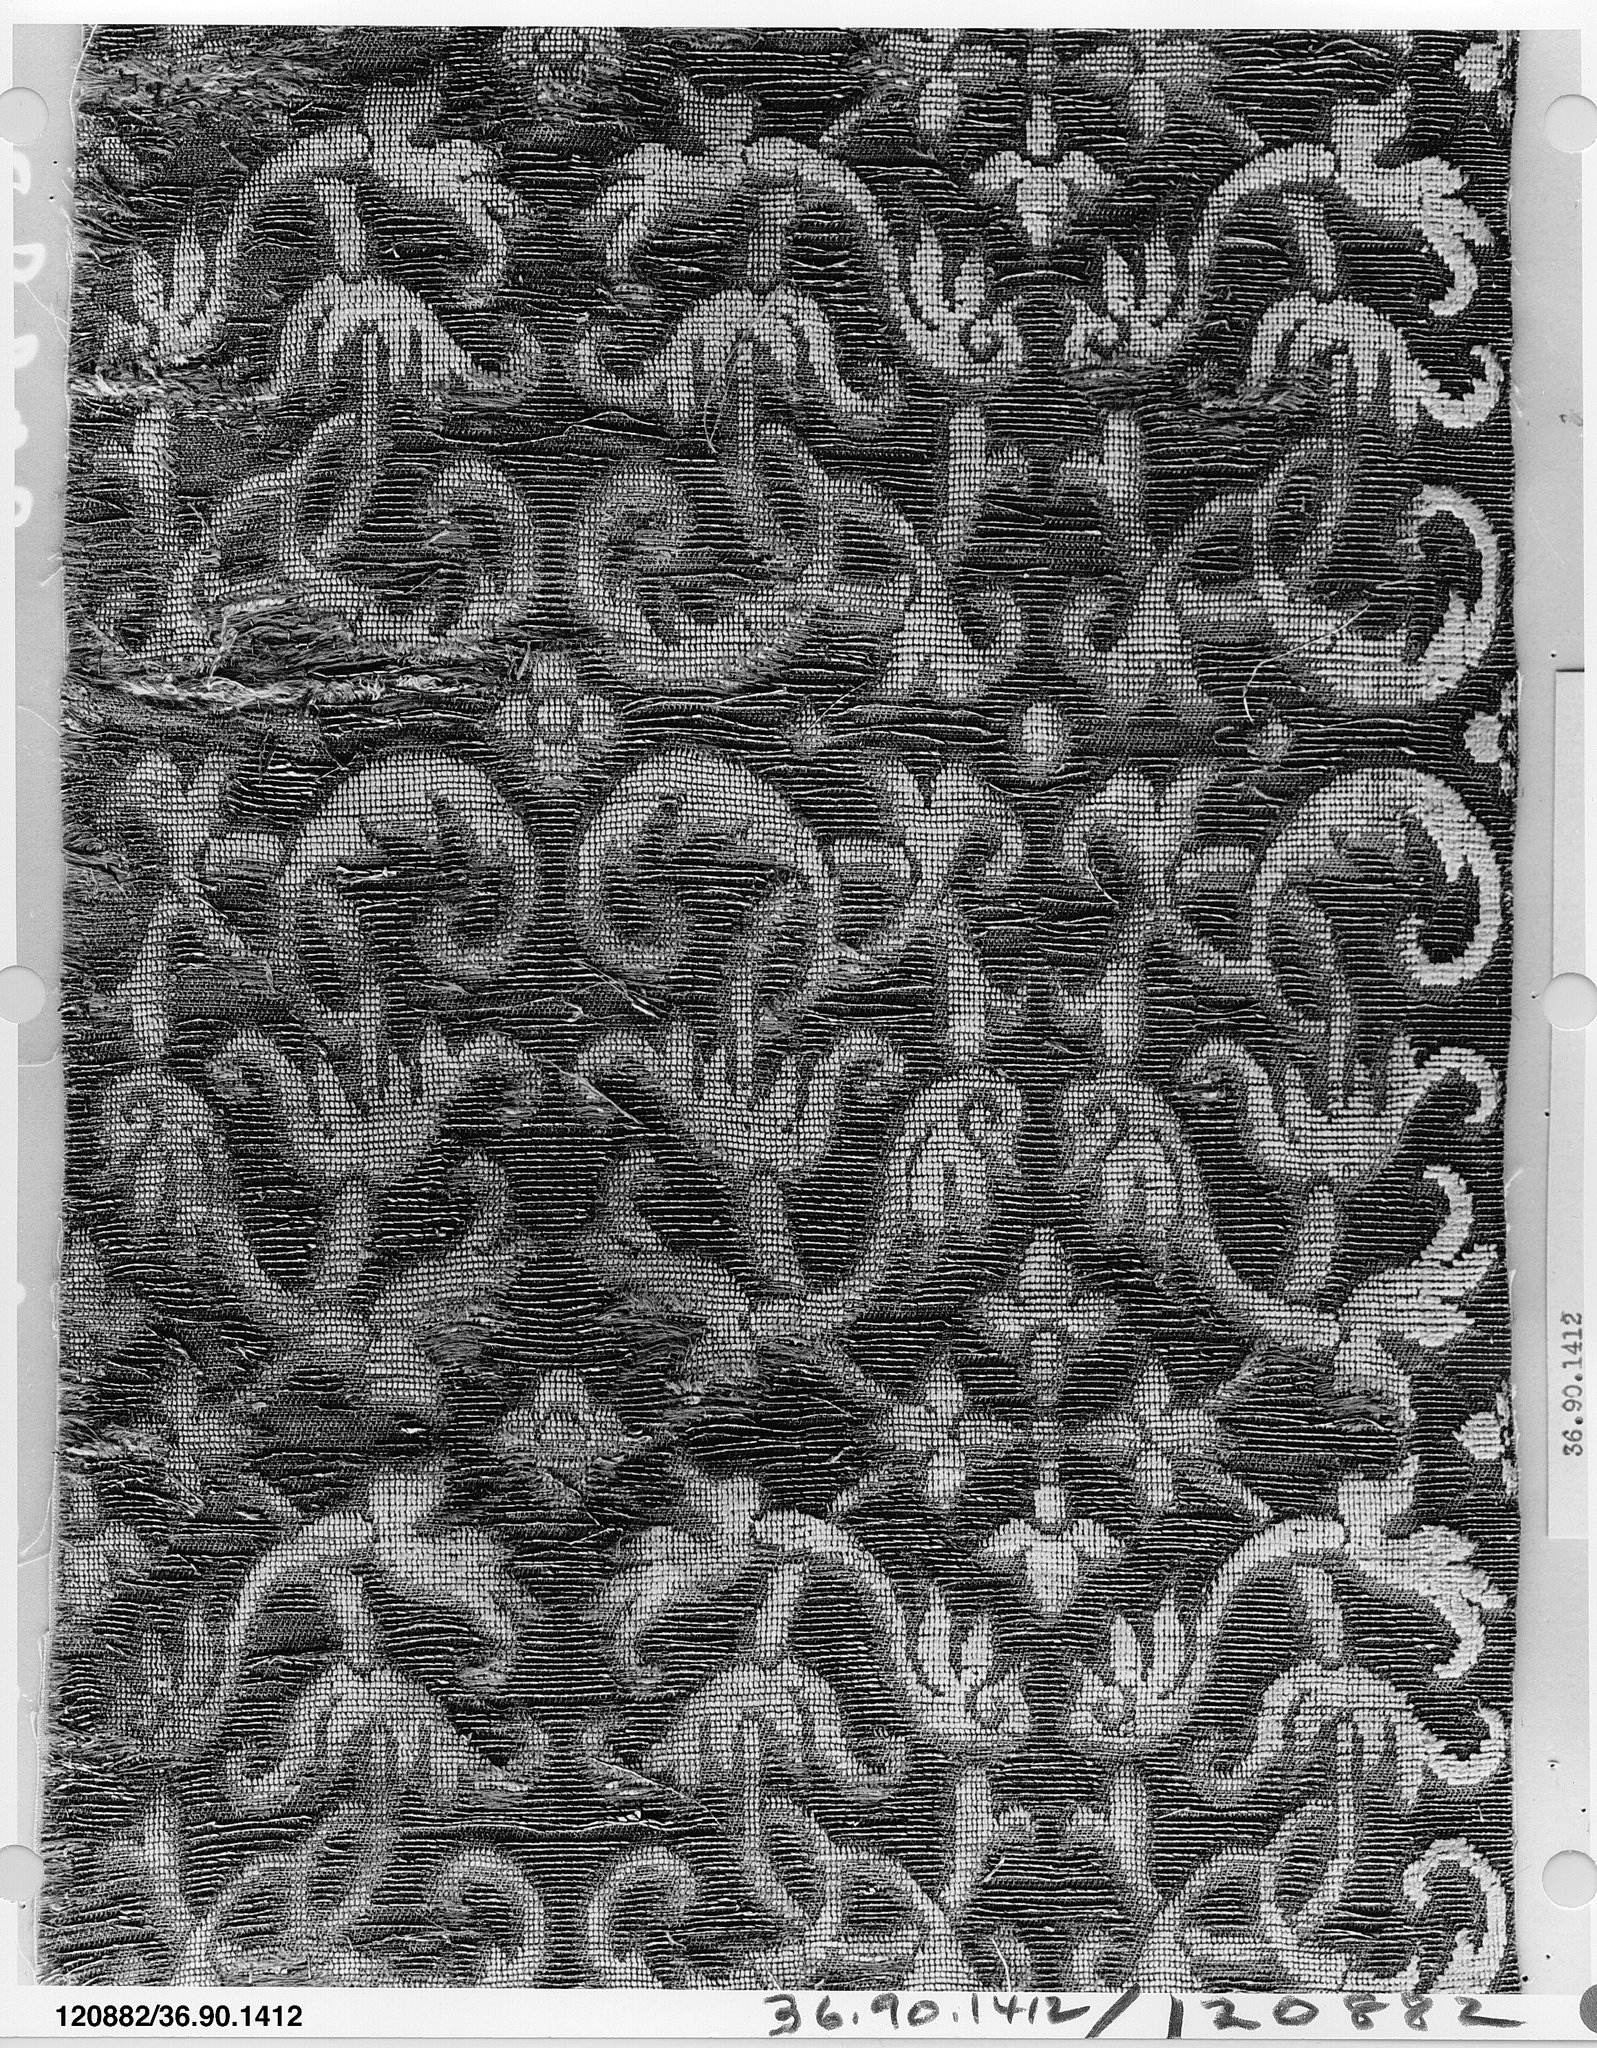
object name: piece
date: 1601-1700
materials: silk, skin